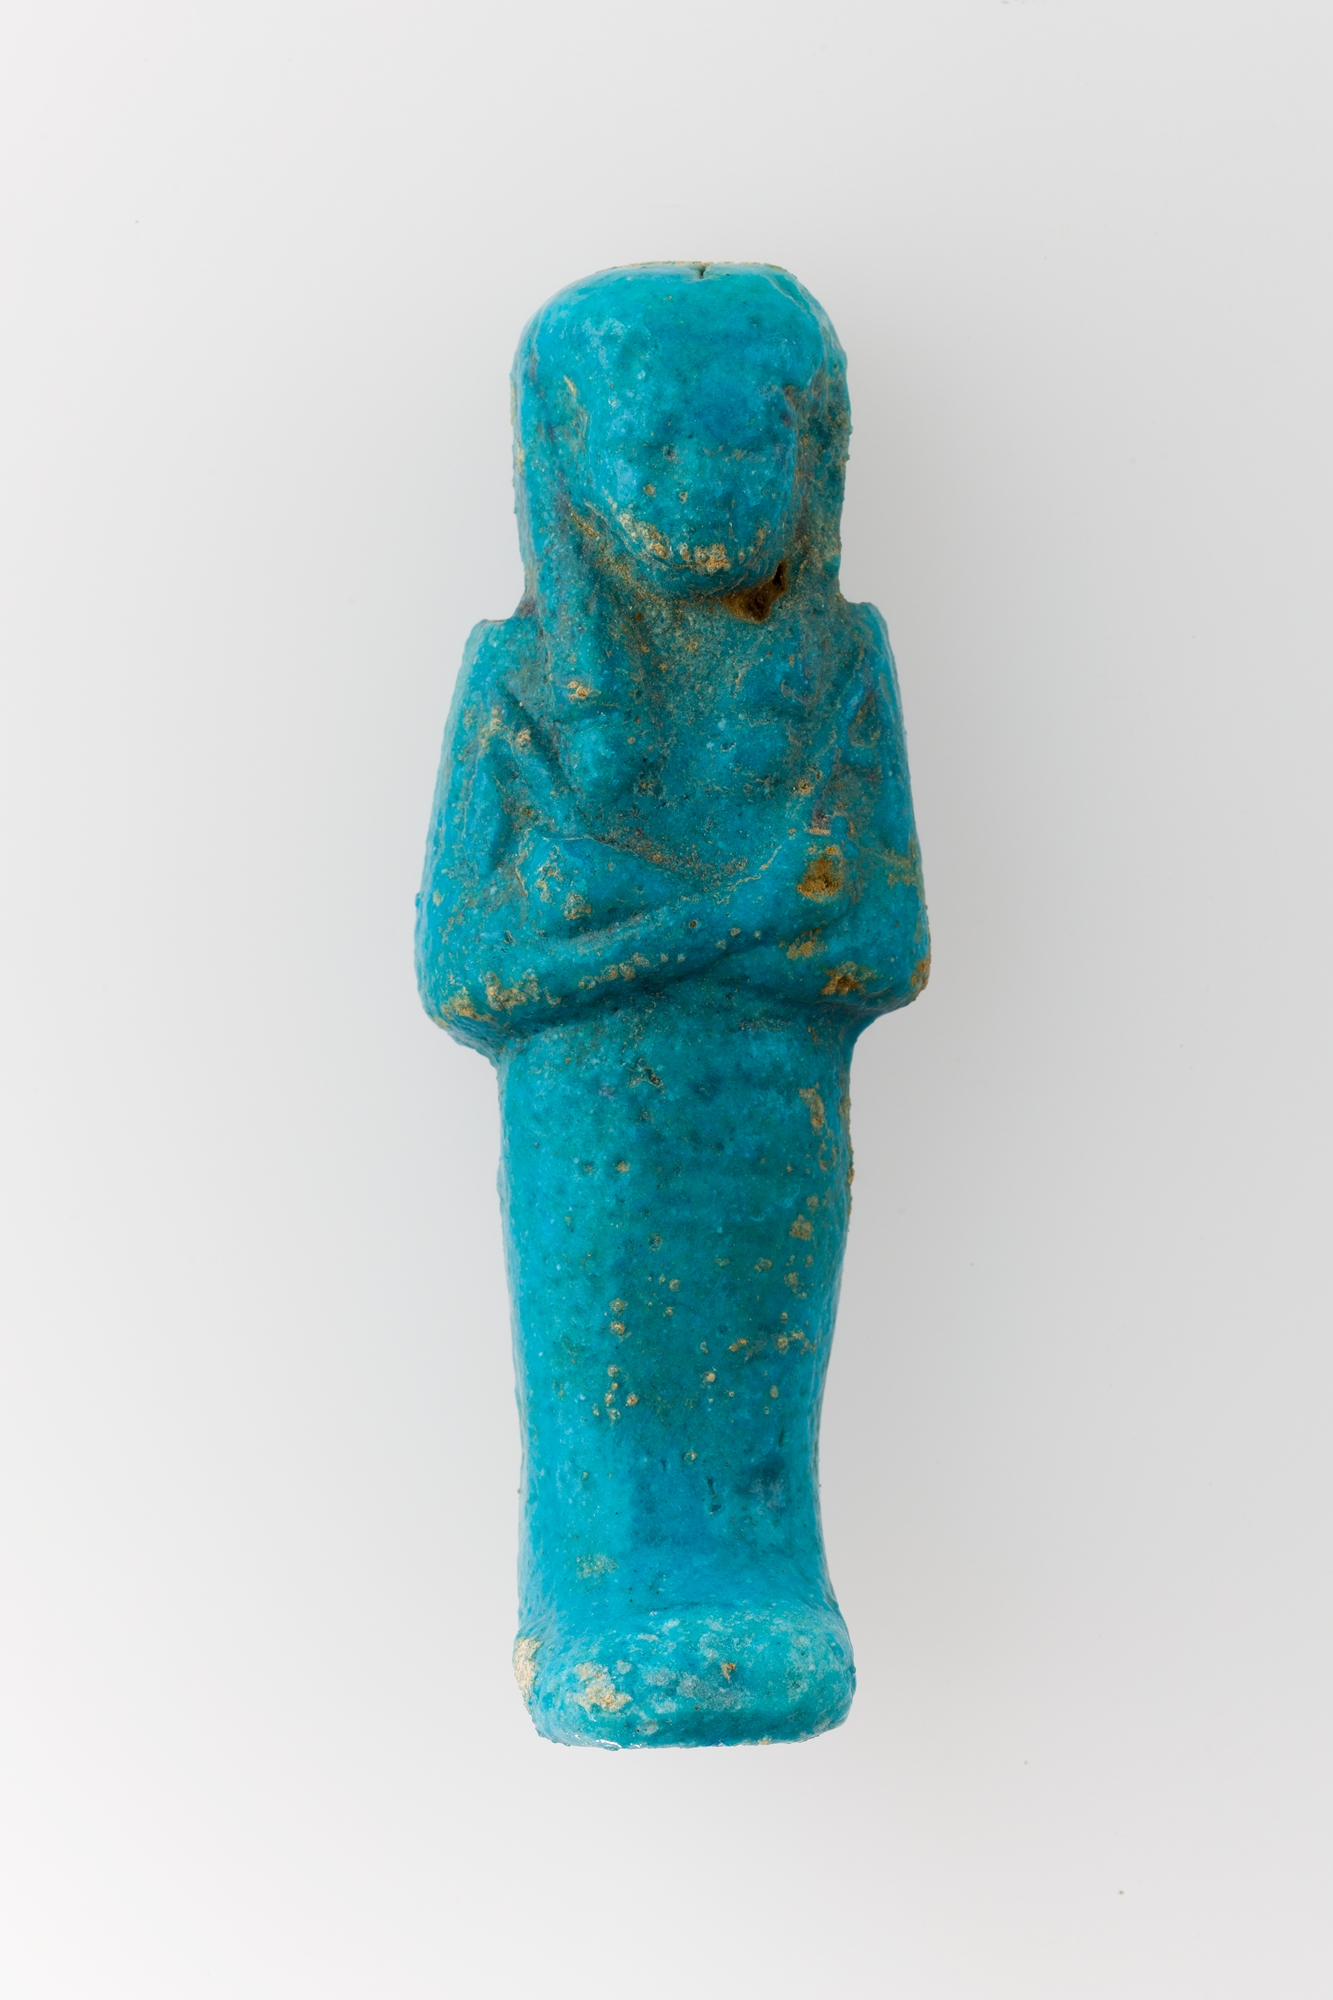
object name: shabti, henettawy c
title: Worker Shabti of Henettawy (C), Daughter of Isetemkheb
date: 990-970 BCE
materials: faience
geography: egypt